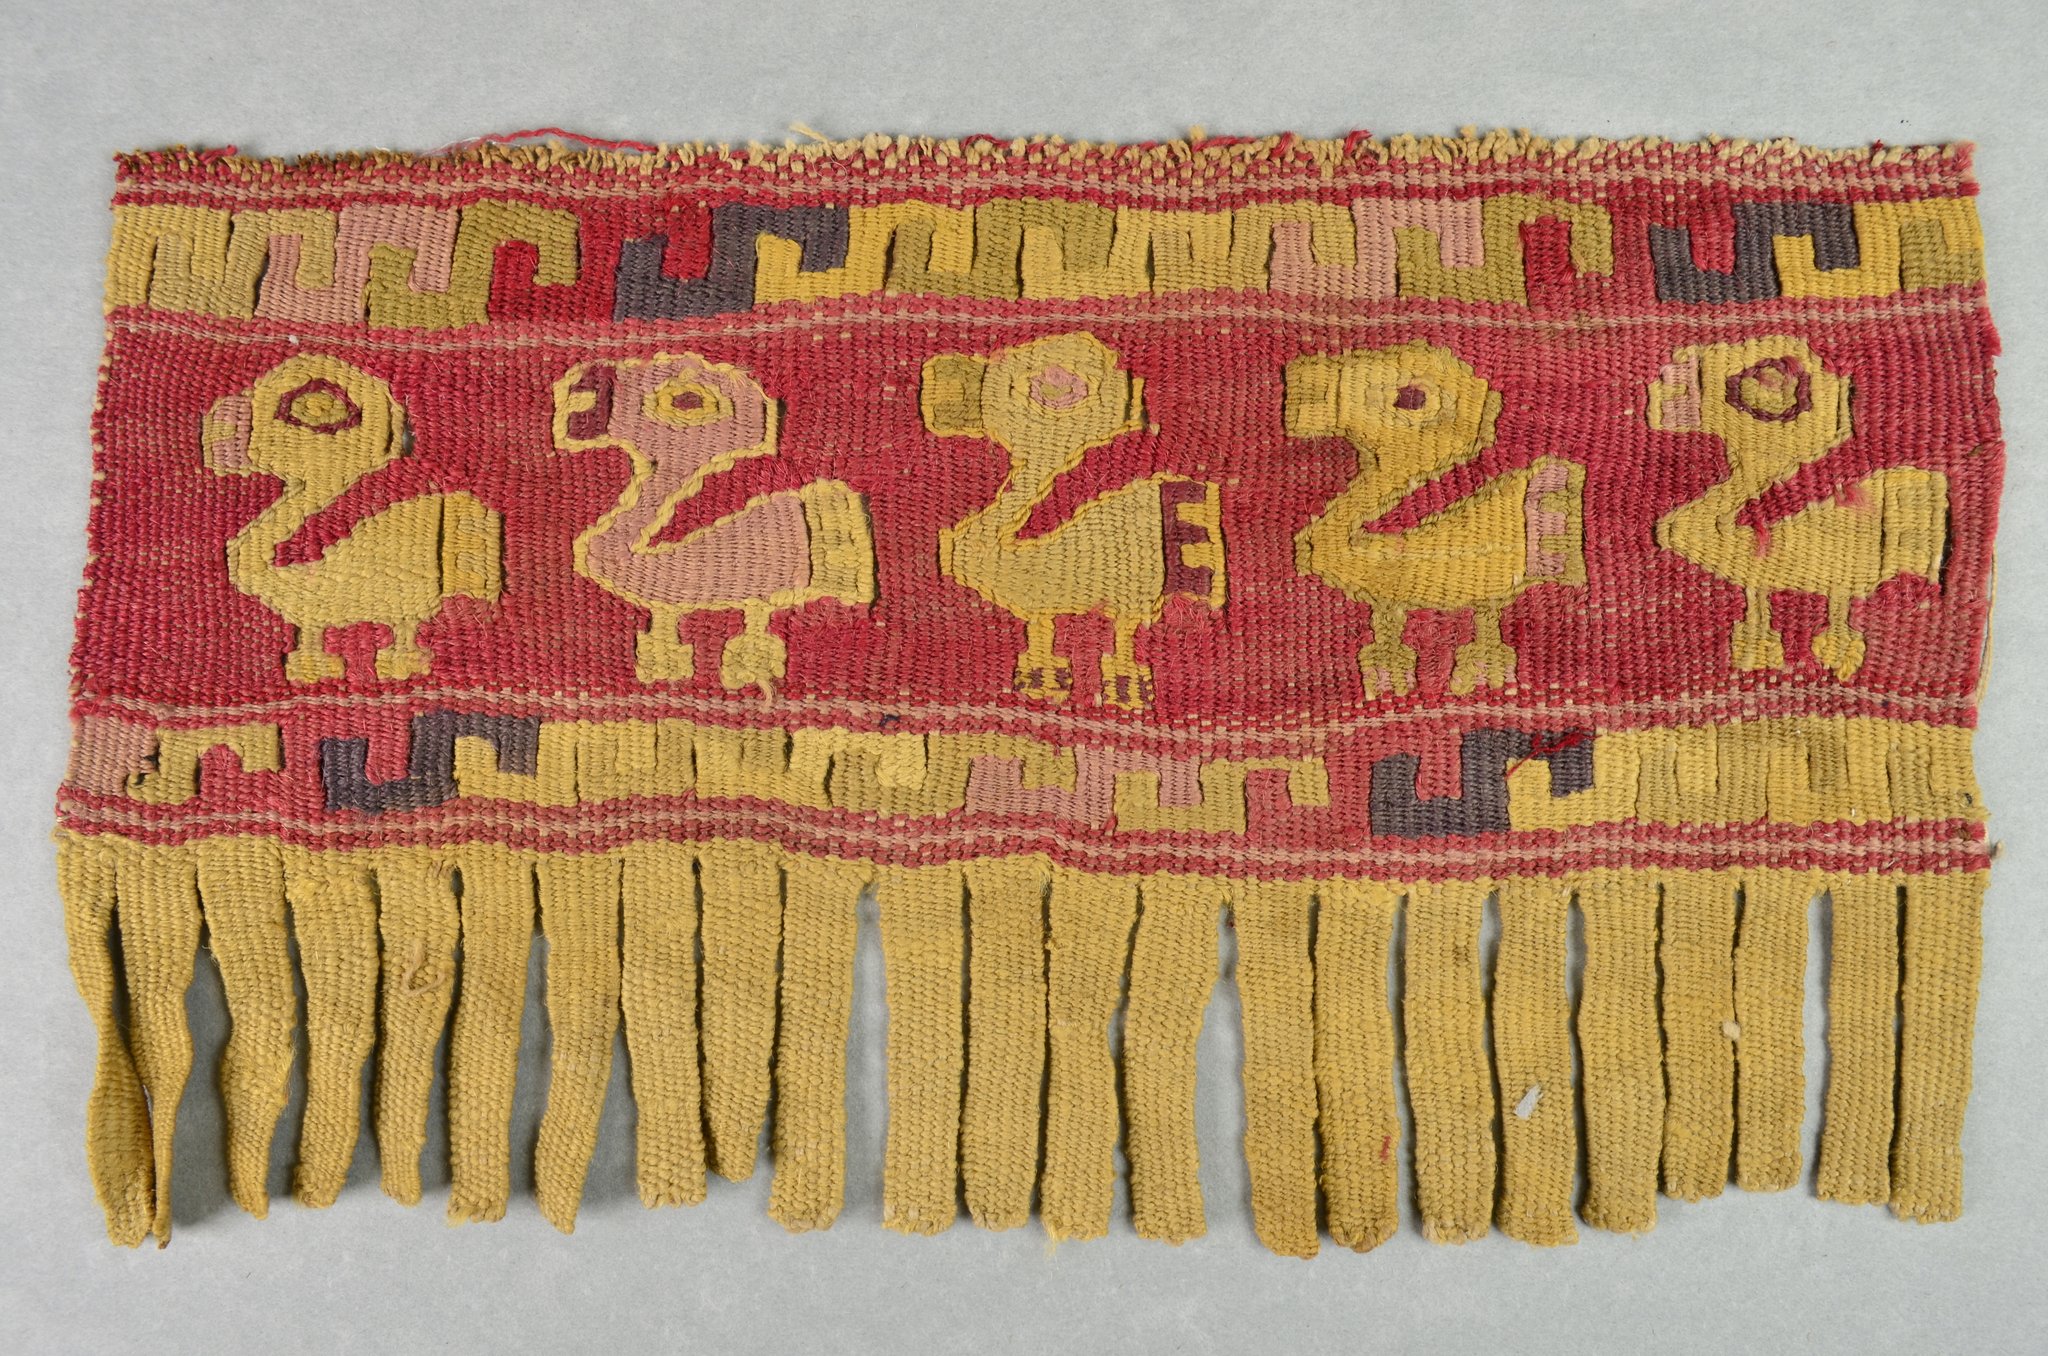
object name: fragment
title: Border Fragment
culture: chimú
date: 1101-1400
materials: animal fiber, cotton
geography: peru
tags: birds